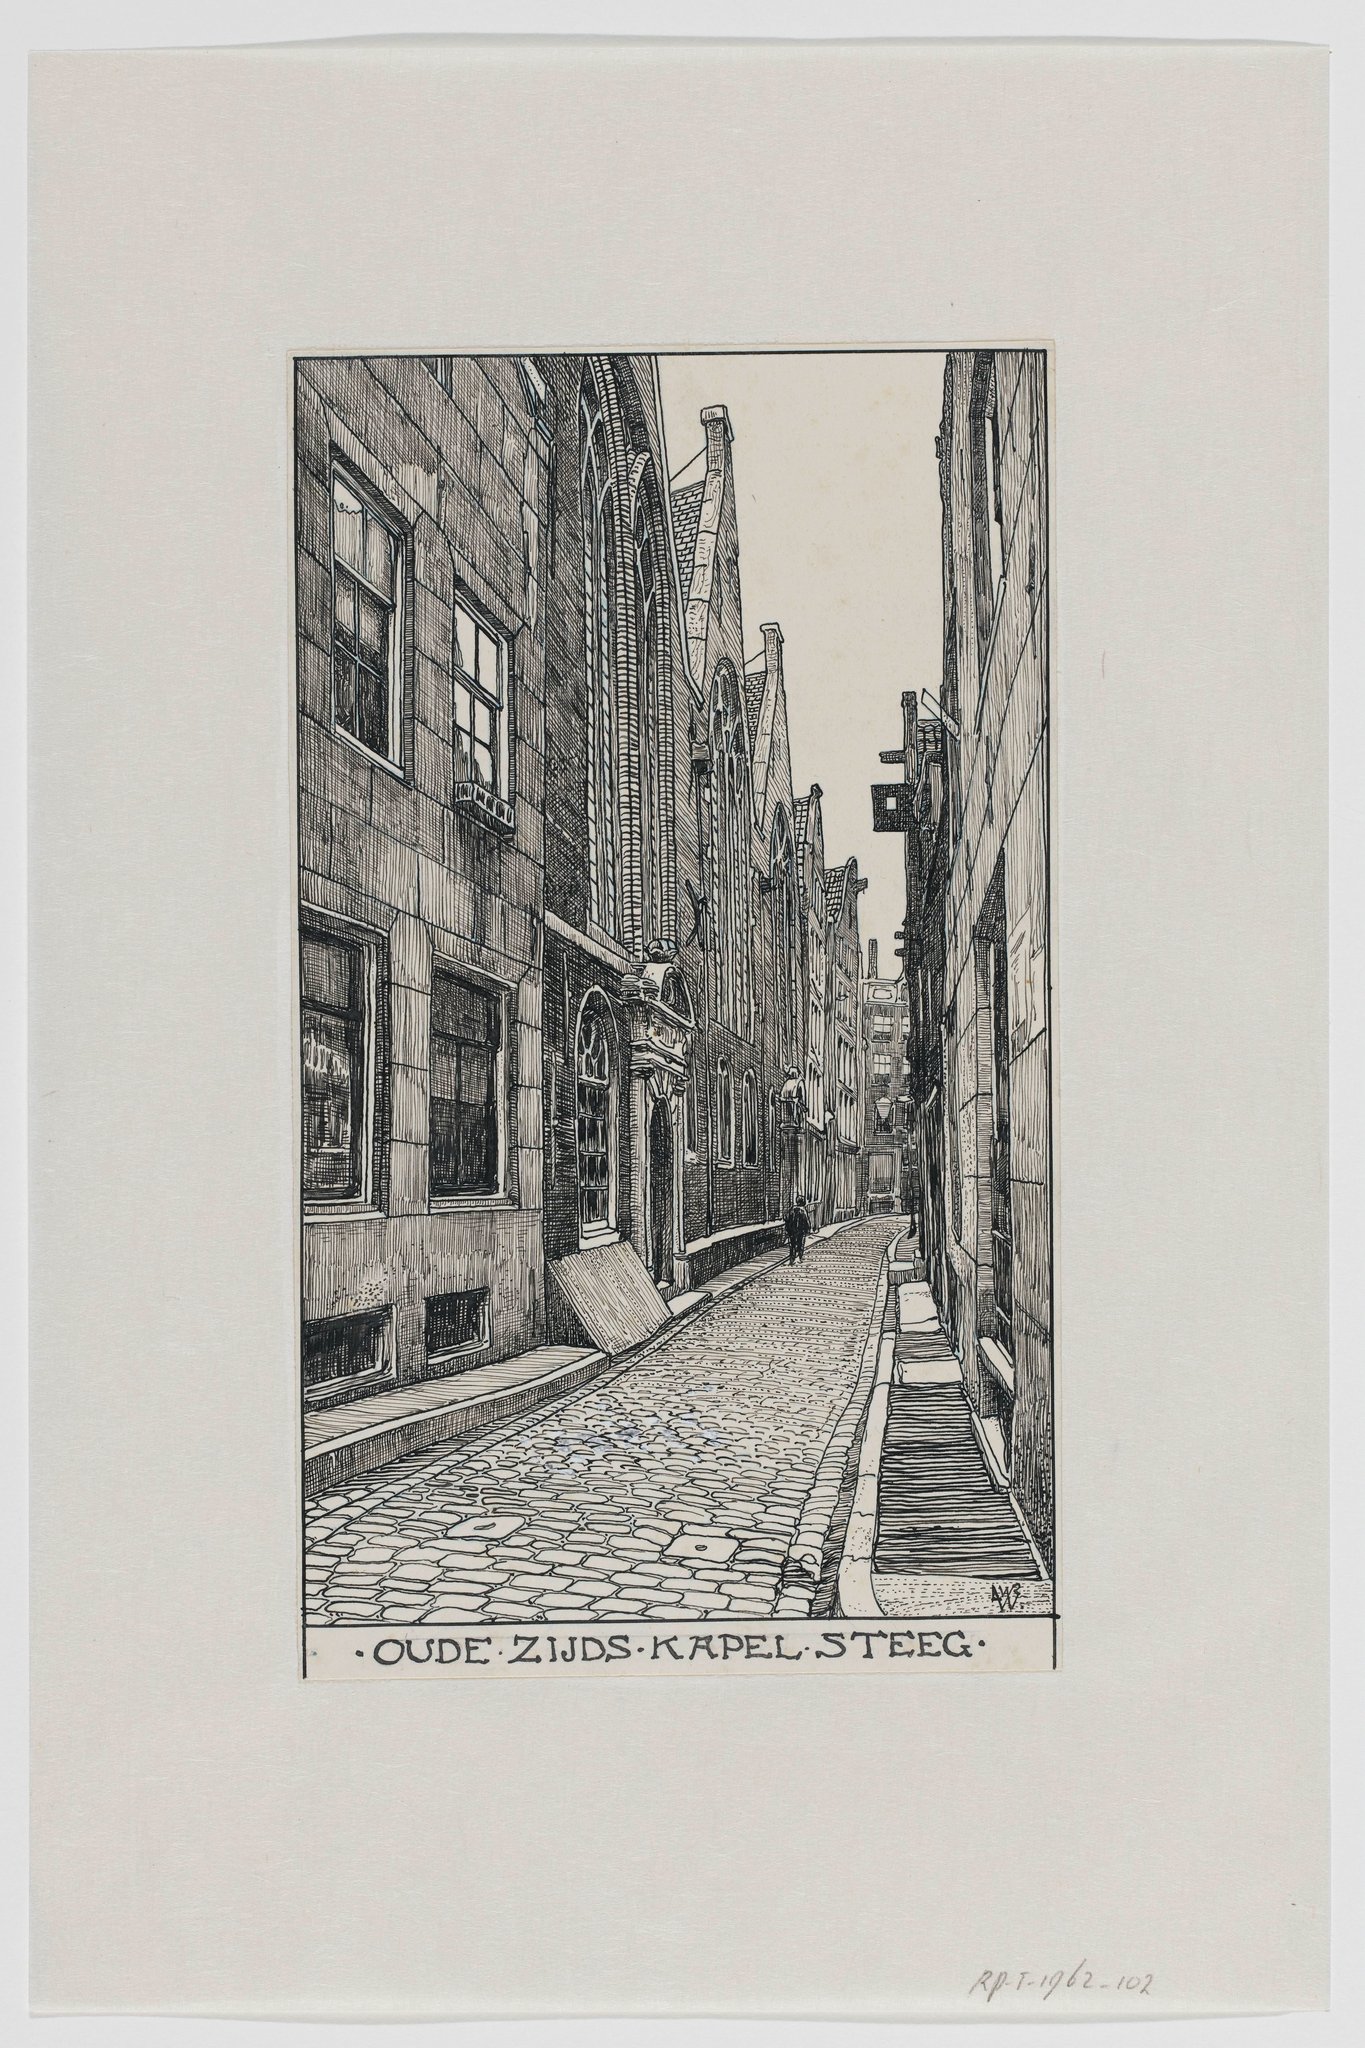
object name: drawing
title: Oude Zijds Kapel Steeg te Amsterdam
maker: willem wenckebach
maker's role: designer, draughtsman, painter, print maker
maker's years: 1860-1937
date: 1870-1926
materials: paint, ink, paper, pencil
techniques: pen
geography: amsterdam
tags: lane, alley